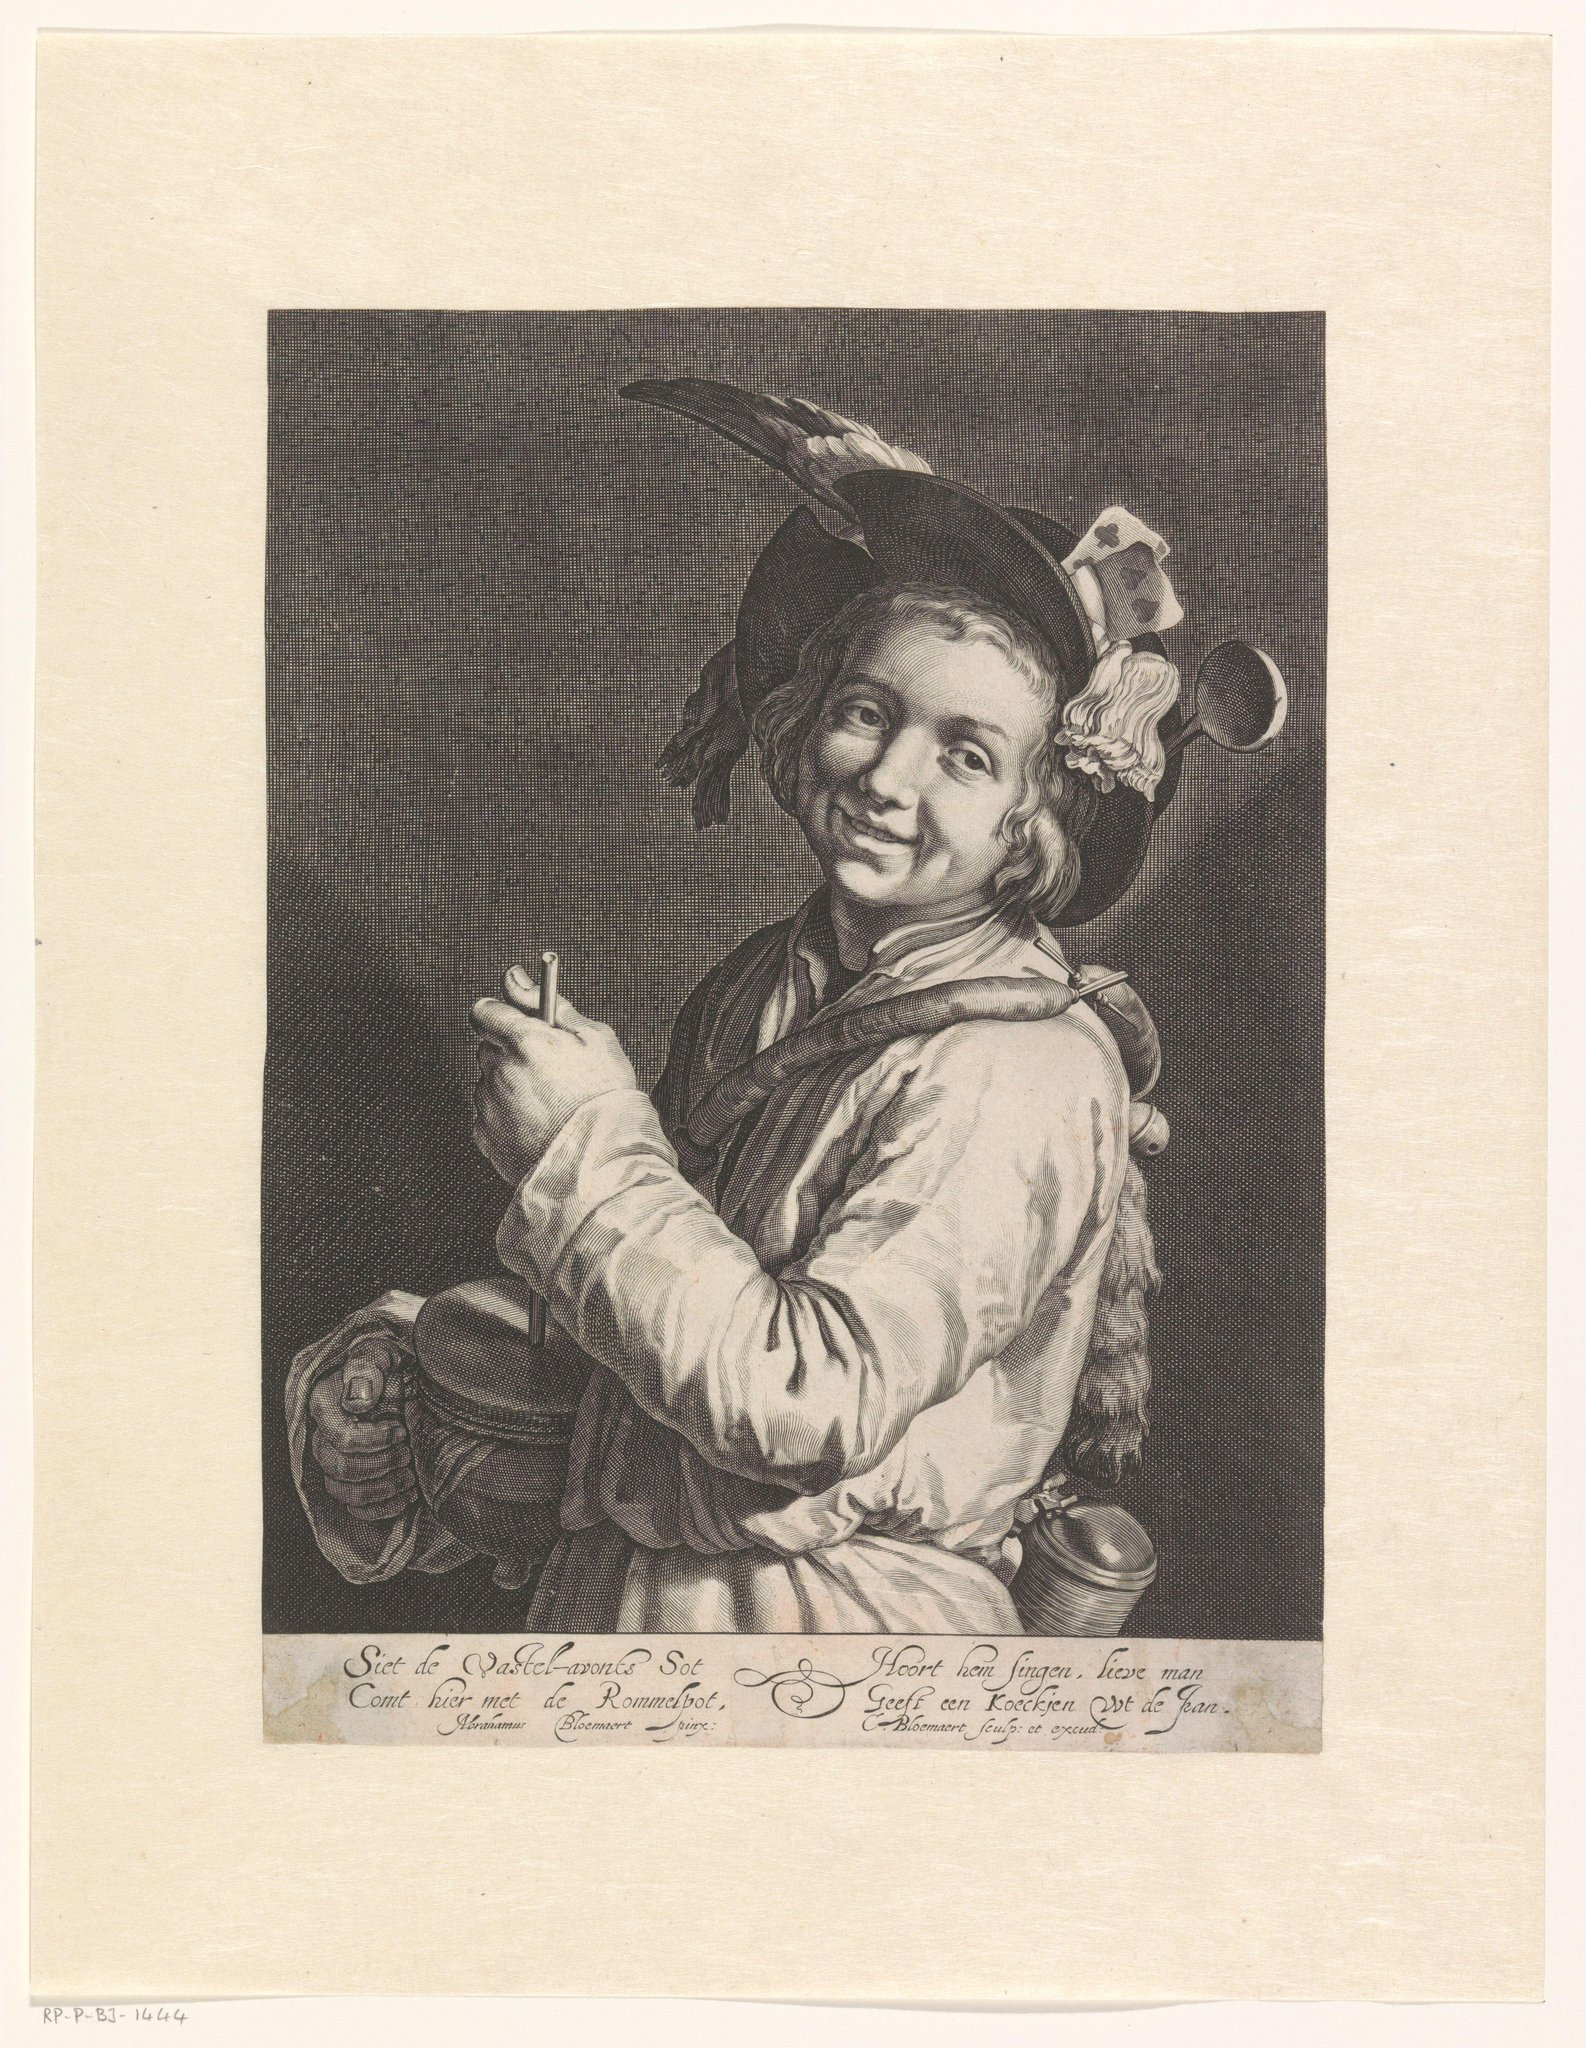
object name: print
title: Rommelpot-speler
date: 1625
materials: paper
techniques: engraving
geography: utrecht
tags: carnival, shrovetide (non-liturgical celebration), improvised musical instruments: rumbling pot, one person playing an instrument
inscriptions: collector's mark: Lugt 240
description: Een jongen maakt muziek met een rommelpot. De jongen is carnevalesk gekleed. Zijn hoed is versierd met een pollepel, kaarten en veren. Om zijn schouder draagt hij een ketting van worsten. Met tweeregelig Nederlands onderschrift.